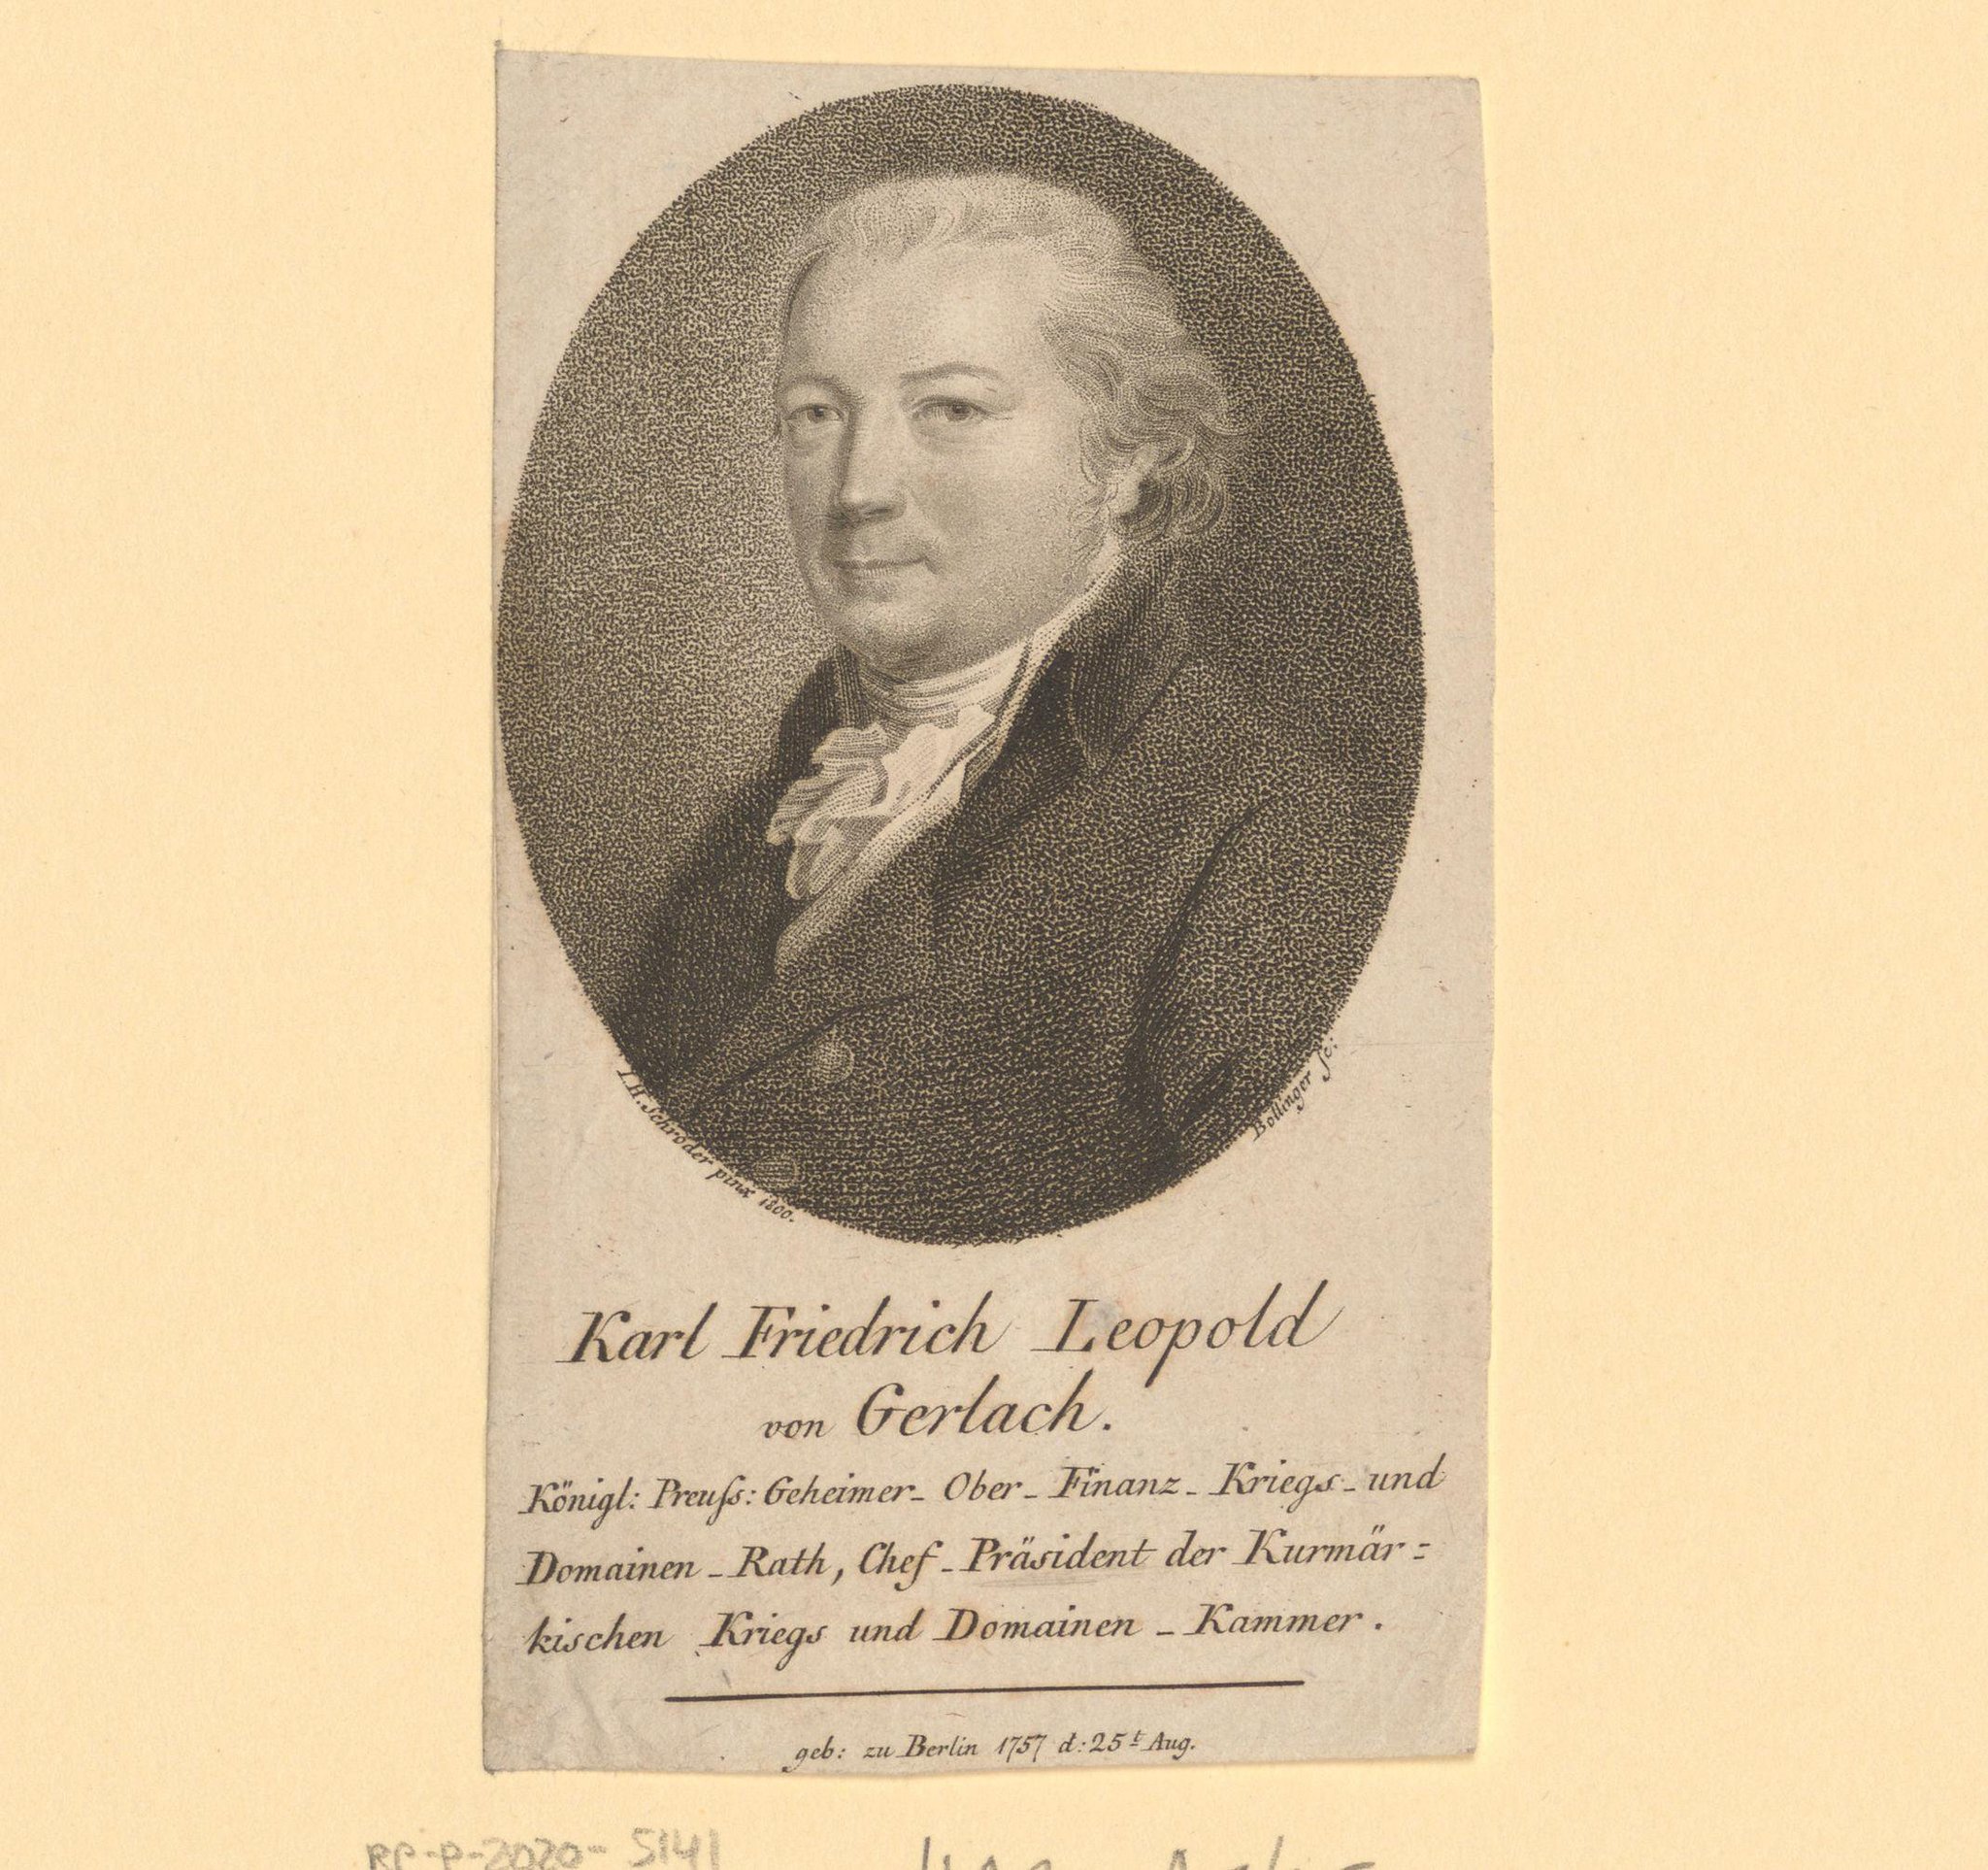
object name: print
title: Portret van Carl Friedrich Leopold von Gerlach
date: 1800-1801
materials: paper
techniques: stippling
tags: mayor, historical persons, portrait of a writer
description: Prent mogelijk uit: Neue Berlinische Monatschrift 5 (1801). Berlijn en Stettin: Friedrich Nicolai, 1801.